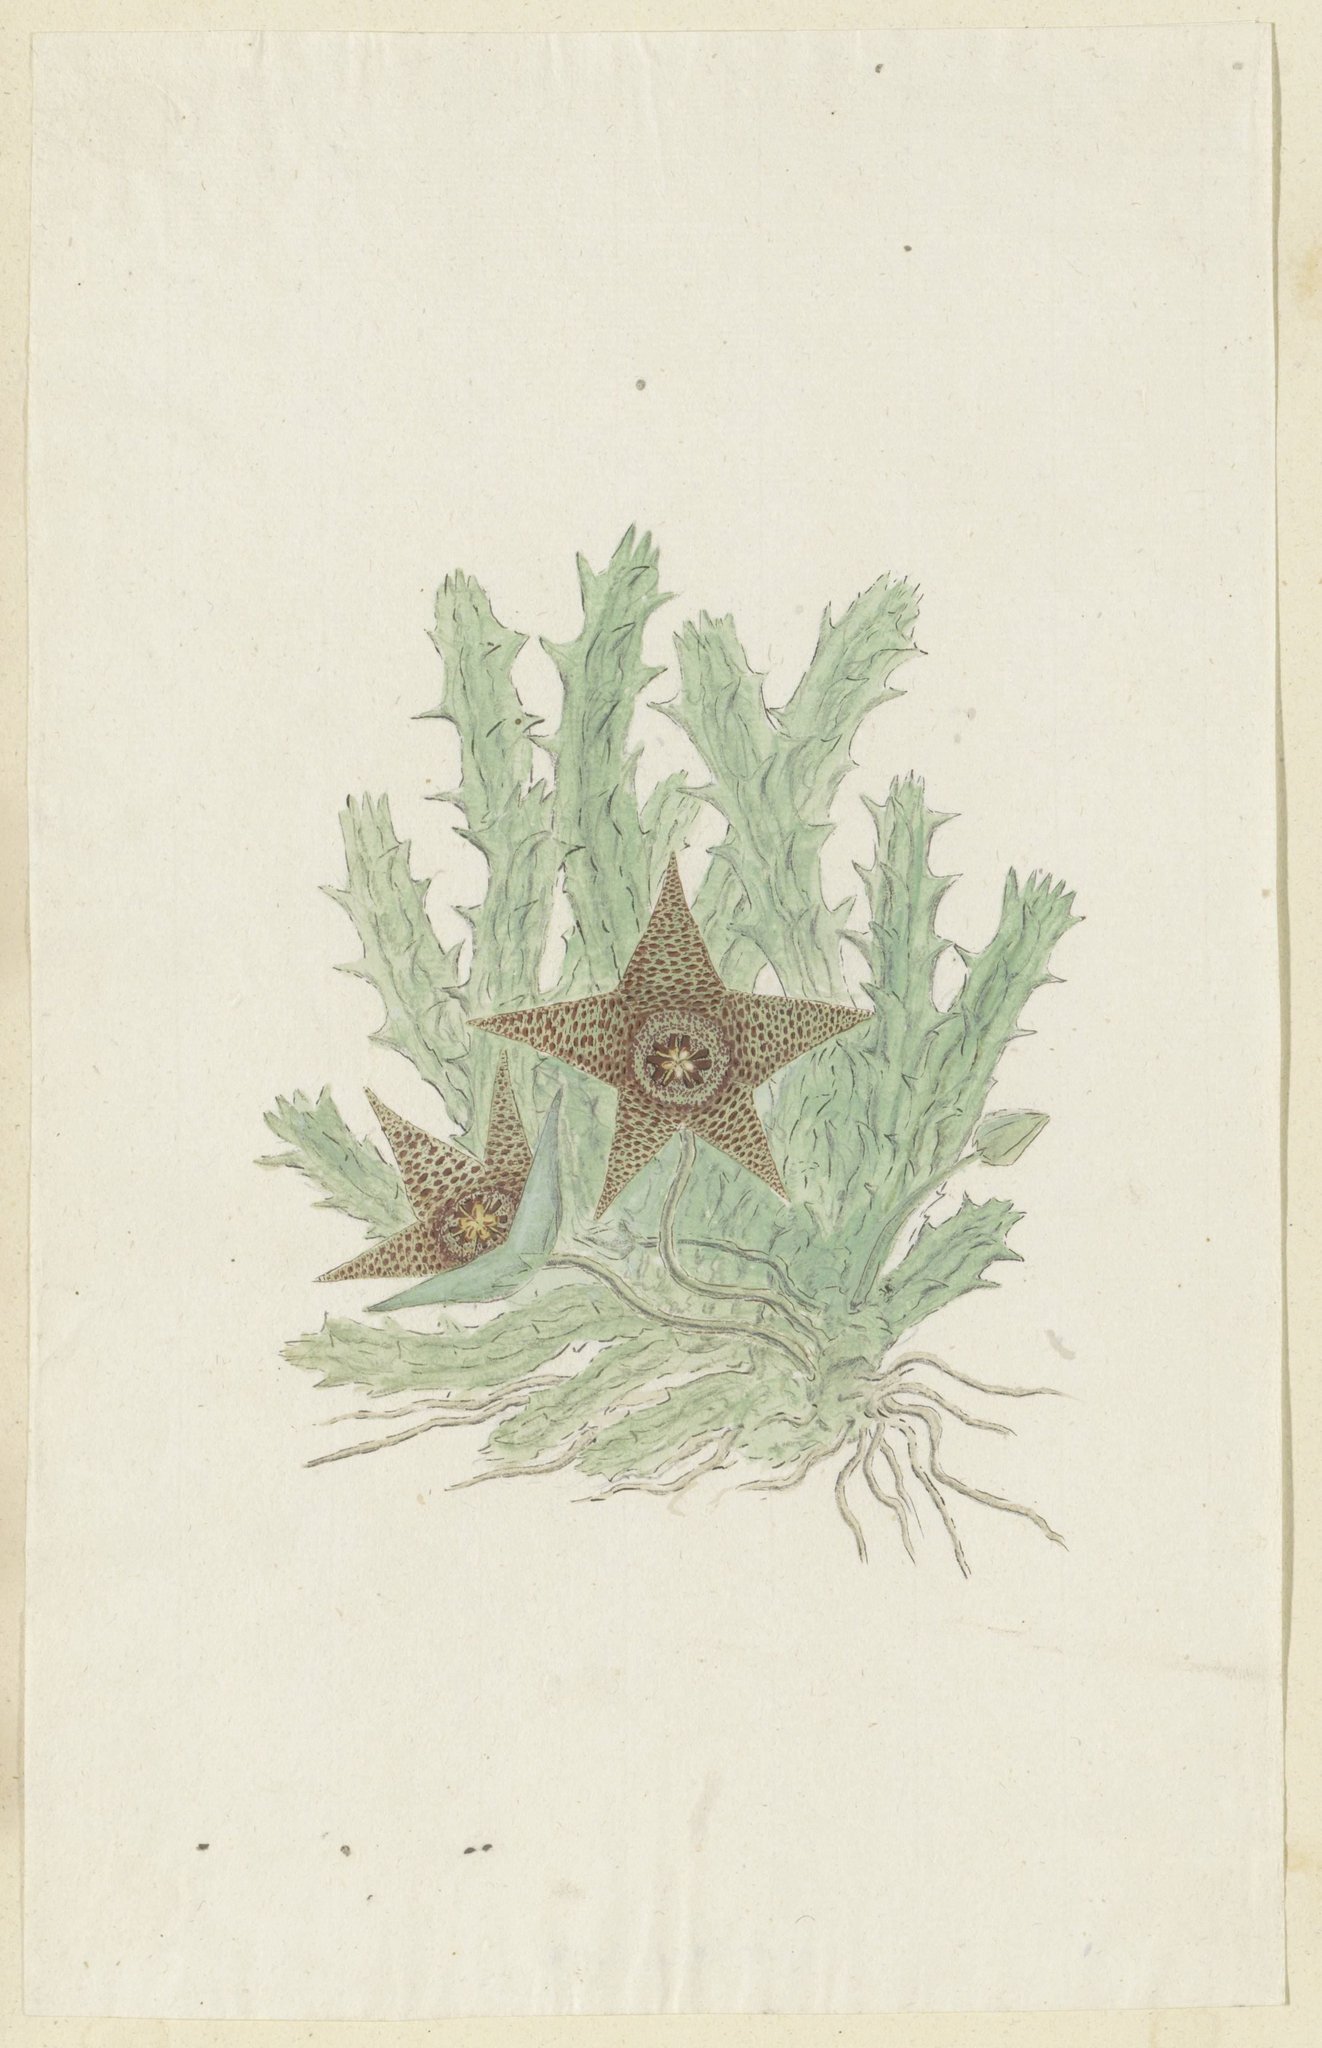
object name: album leaf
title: Orbea verrucosa (Masson) Haw. (Hirsute Stapelia)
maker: robert jacob gordon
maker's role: draughtsman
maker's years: 1743-1795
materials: chalk, ink, paper, pencil, watercolor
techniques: brush, pen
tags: plants; vegetation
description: De tekening is gemaakt voor of tijdens een van Gordon's vier expedities door de Kaapprovincie, van oktober 1777 tot maart 1786. Sommige (soort)namen kunnen zijn gewijzigd, gezien reorganisatie in plantentaxonomie gedurende de afgelopen jaren.